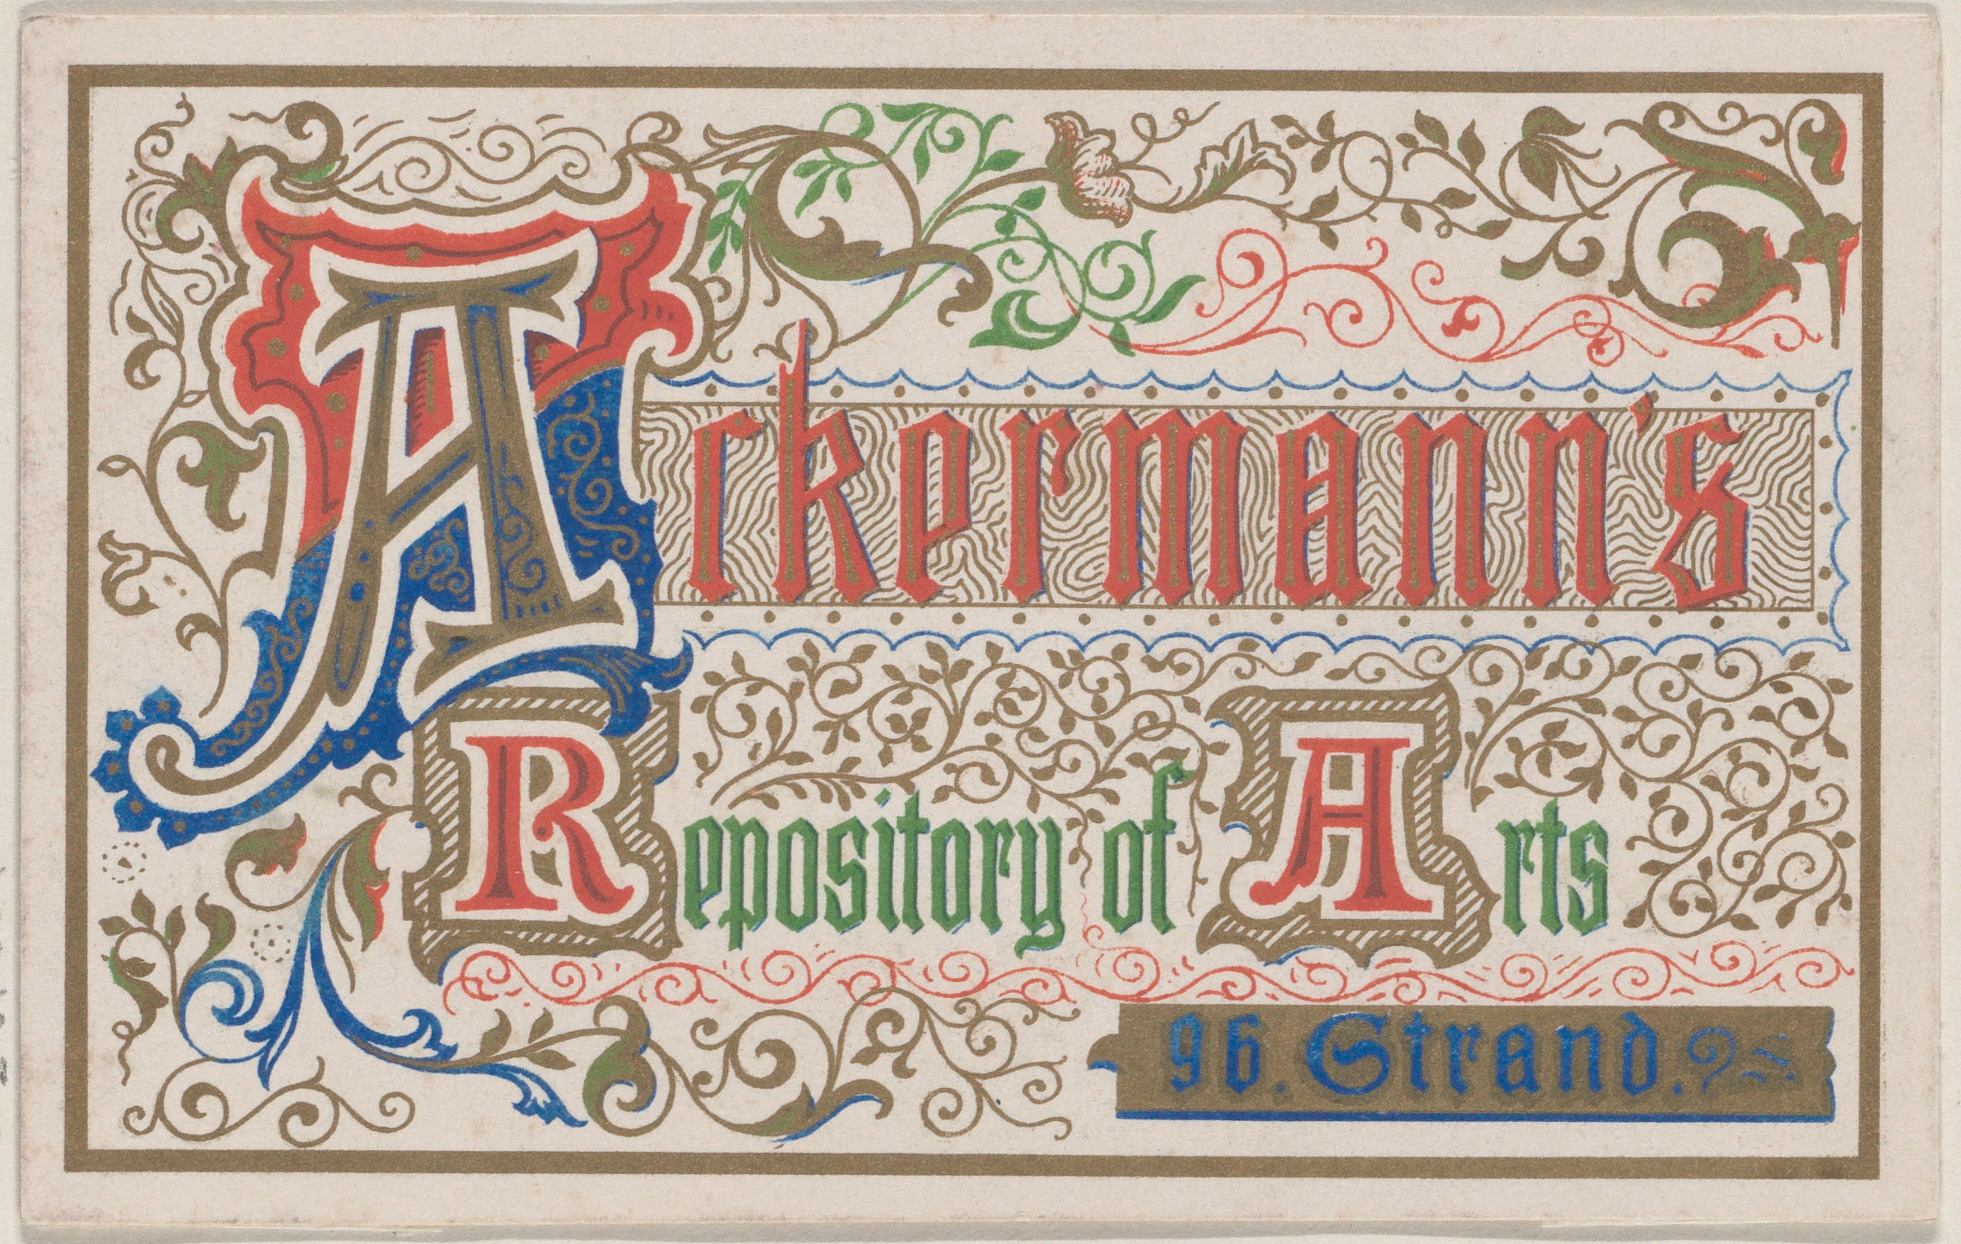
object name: print, trade card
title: Trade Card for Ackerman's Repository of Arts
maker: anonymous, british, 19th century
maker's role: artist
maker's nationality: british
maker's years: 1800-1900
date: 1801-1900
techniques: lithograph